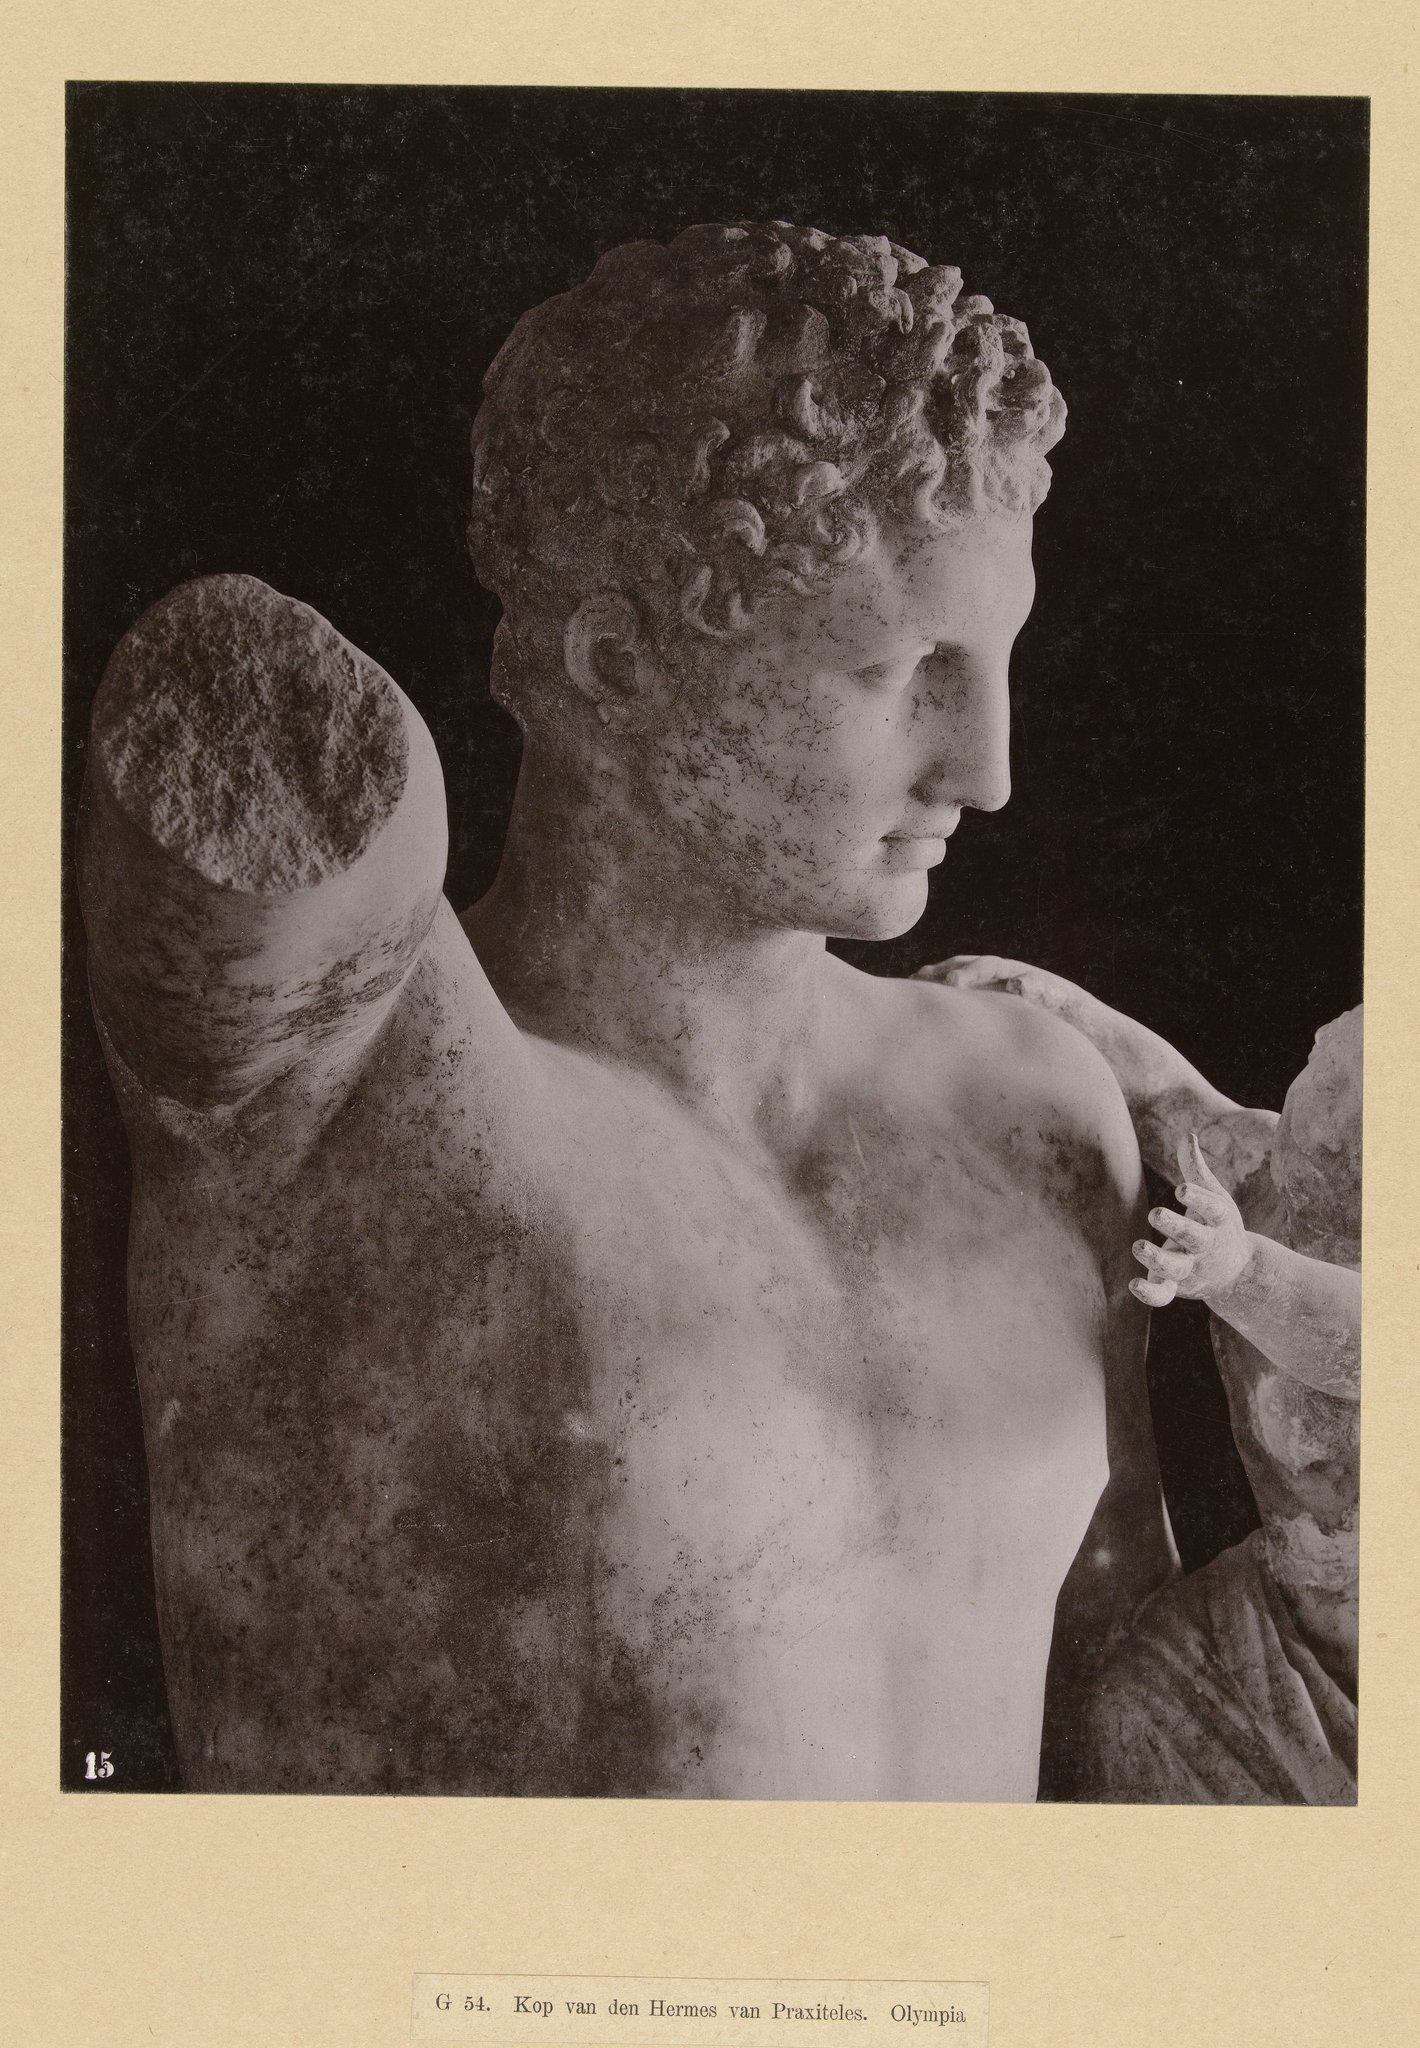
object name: photomechanical print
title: Detail van een beeld van Hermes met het kind Dionysos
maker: Anonymous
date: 1890-1895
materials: cardboard, paper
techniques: photograph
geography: olympia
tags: (story of) mercury (hermes), piece of sculpture, reproduction of a piece of sculpture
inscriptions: check stamp: ‘Bristol/ L.M.’, stamp: ‘Gemeentelijke bibliotheek/ Rotterdam’, title: ‘G 54. Kop van den Hermes van Praxiteles. Olympia’, number: ‘15’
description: Onderdeel van een groep door fotograaf Richard Polak op reis verzamelde foto’s. Deze fotomechanische afdruk is samen met andere op zijn reizen verzamelde foto's tentoongesteld bij de Rotterdamsche Kunstkring (1895), Arti en Amicitiae te Amsterdam (1897-1898?) en Societeit 't Collegie te Kampen (datum vooralsnog onbekend).